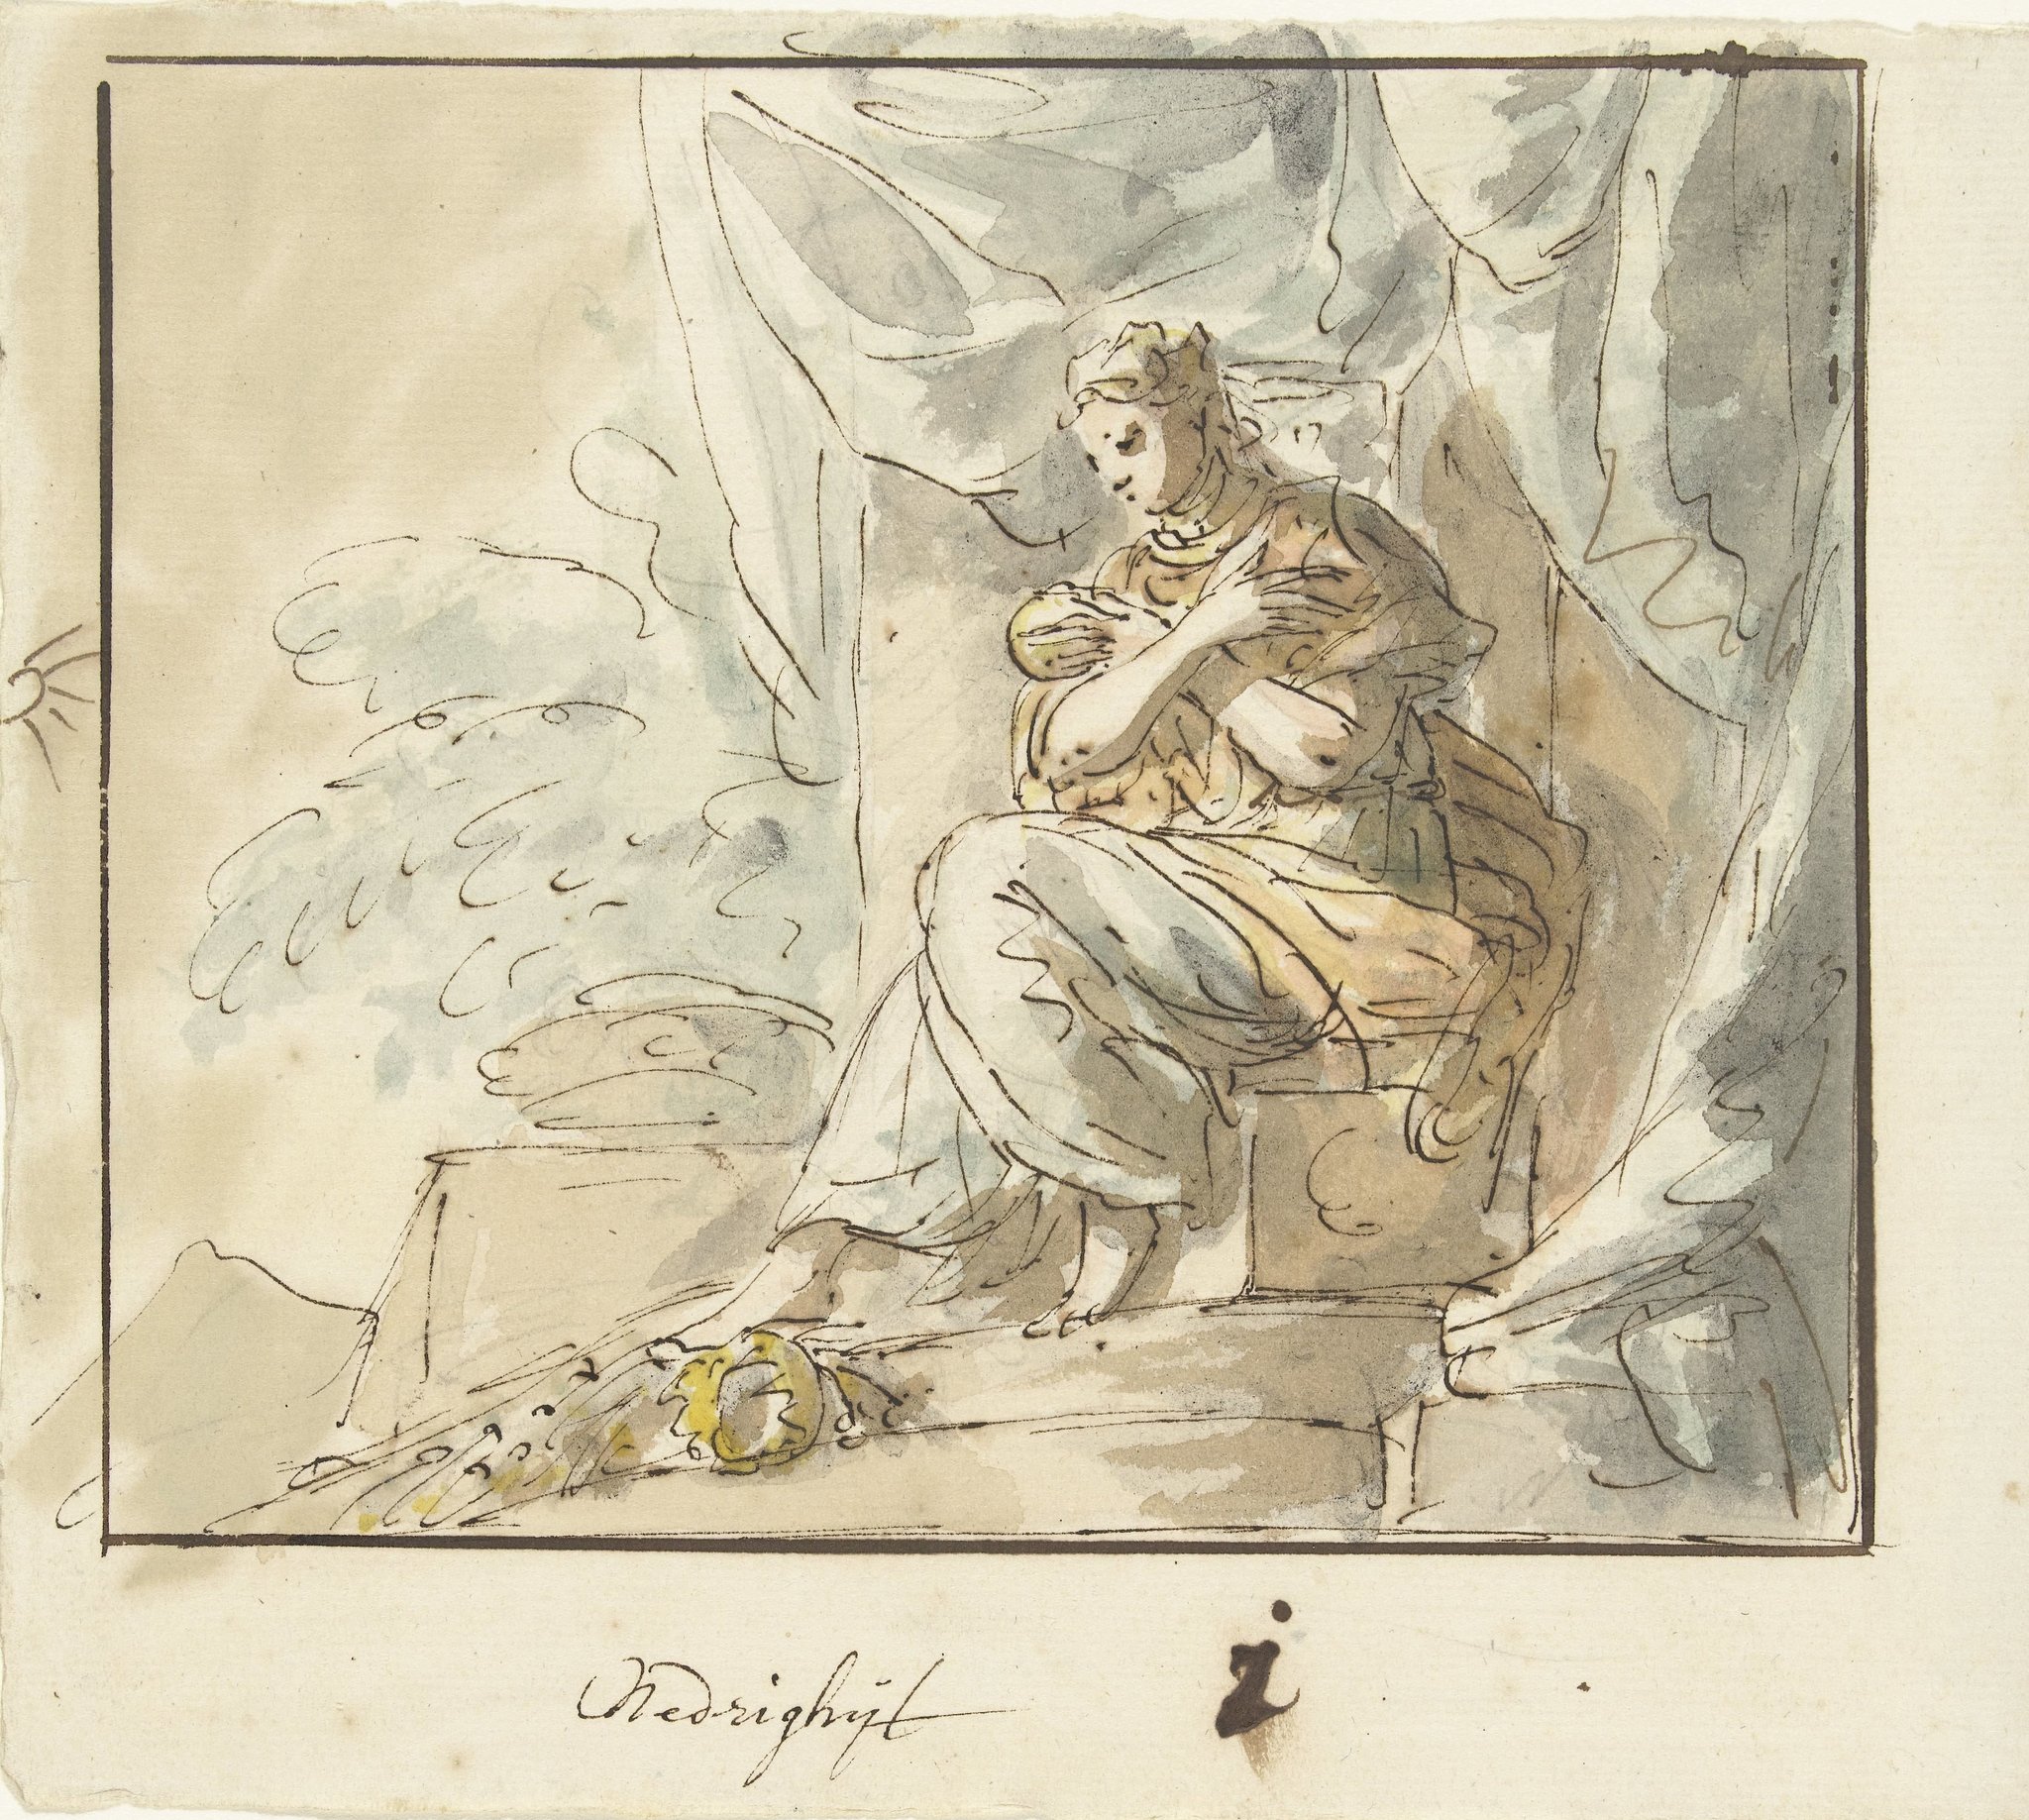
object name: watercolor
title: De Nederigheid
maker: elias van nijmegen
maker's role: draughtsman, painter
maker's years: 1667-1755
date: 1677-1755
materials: ink, paper, pencil, watercolor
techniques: brush, pen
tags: humility; 'humiltà' (ripa) (+ abstract concept represented by female figure)